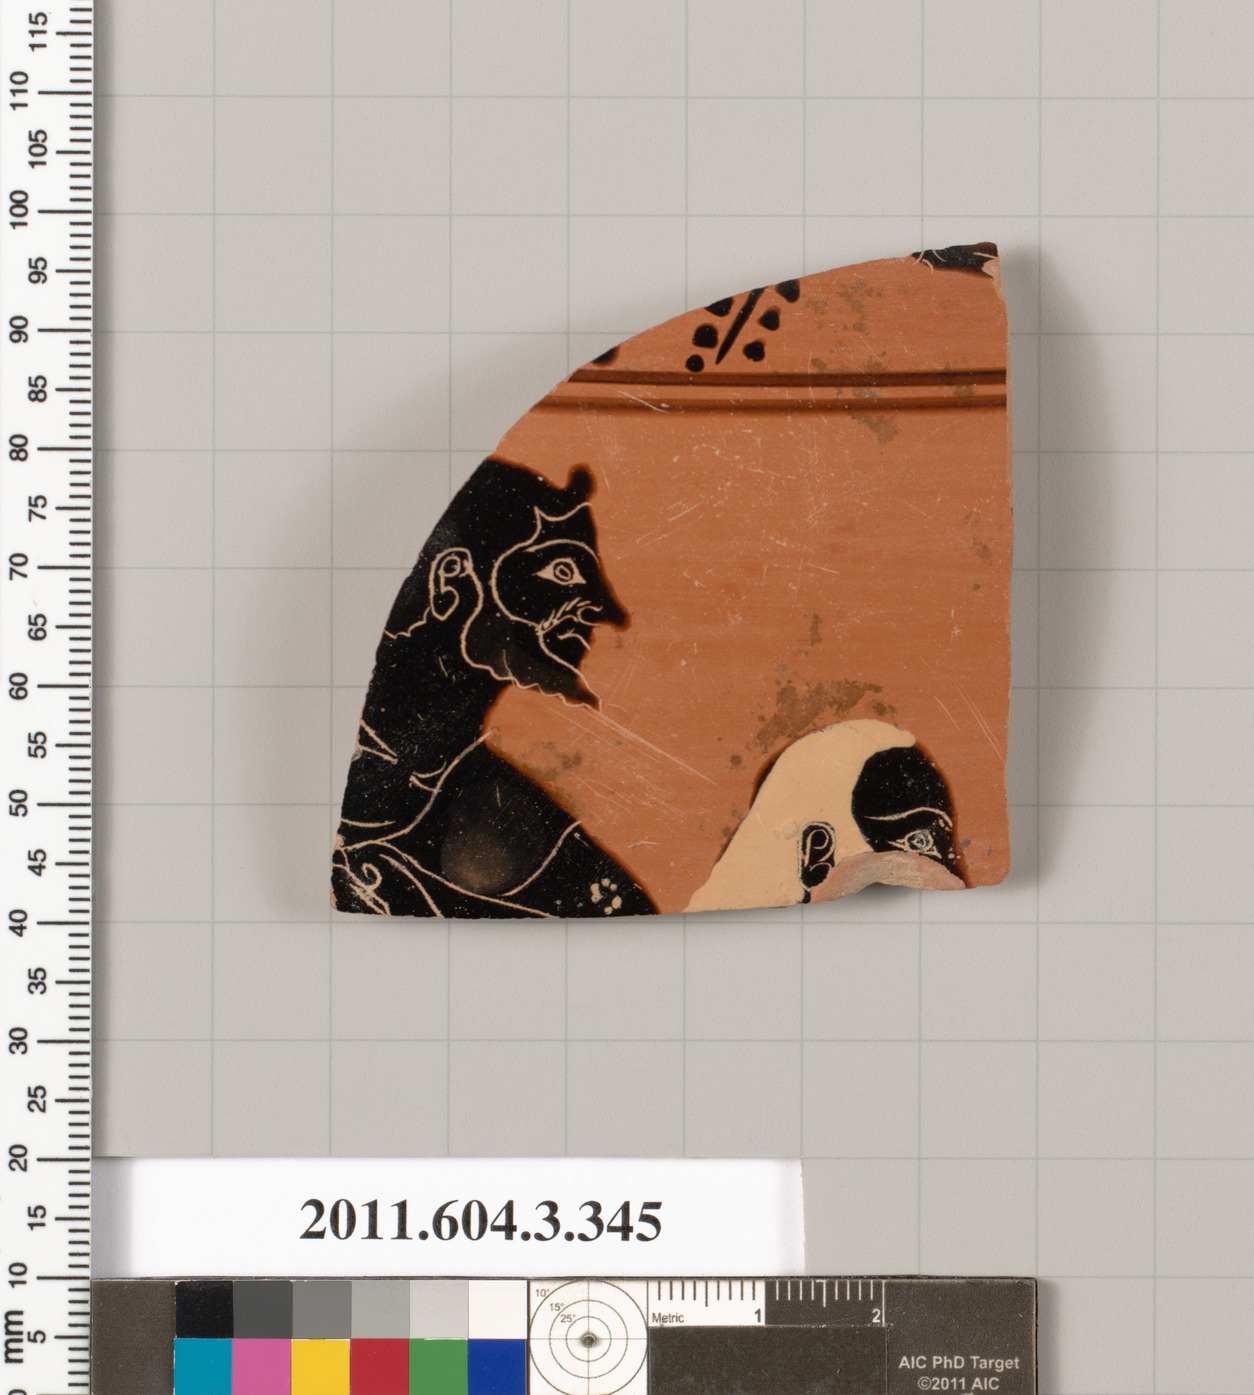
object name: neck amphora fragment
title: Terracotta fragment of a neck-amphora (jar)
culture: greek, attic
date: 550-526 BCE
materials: terracotta